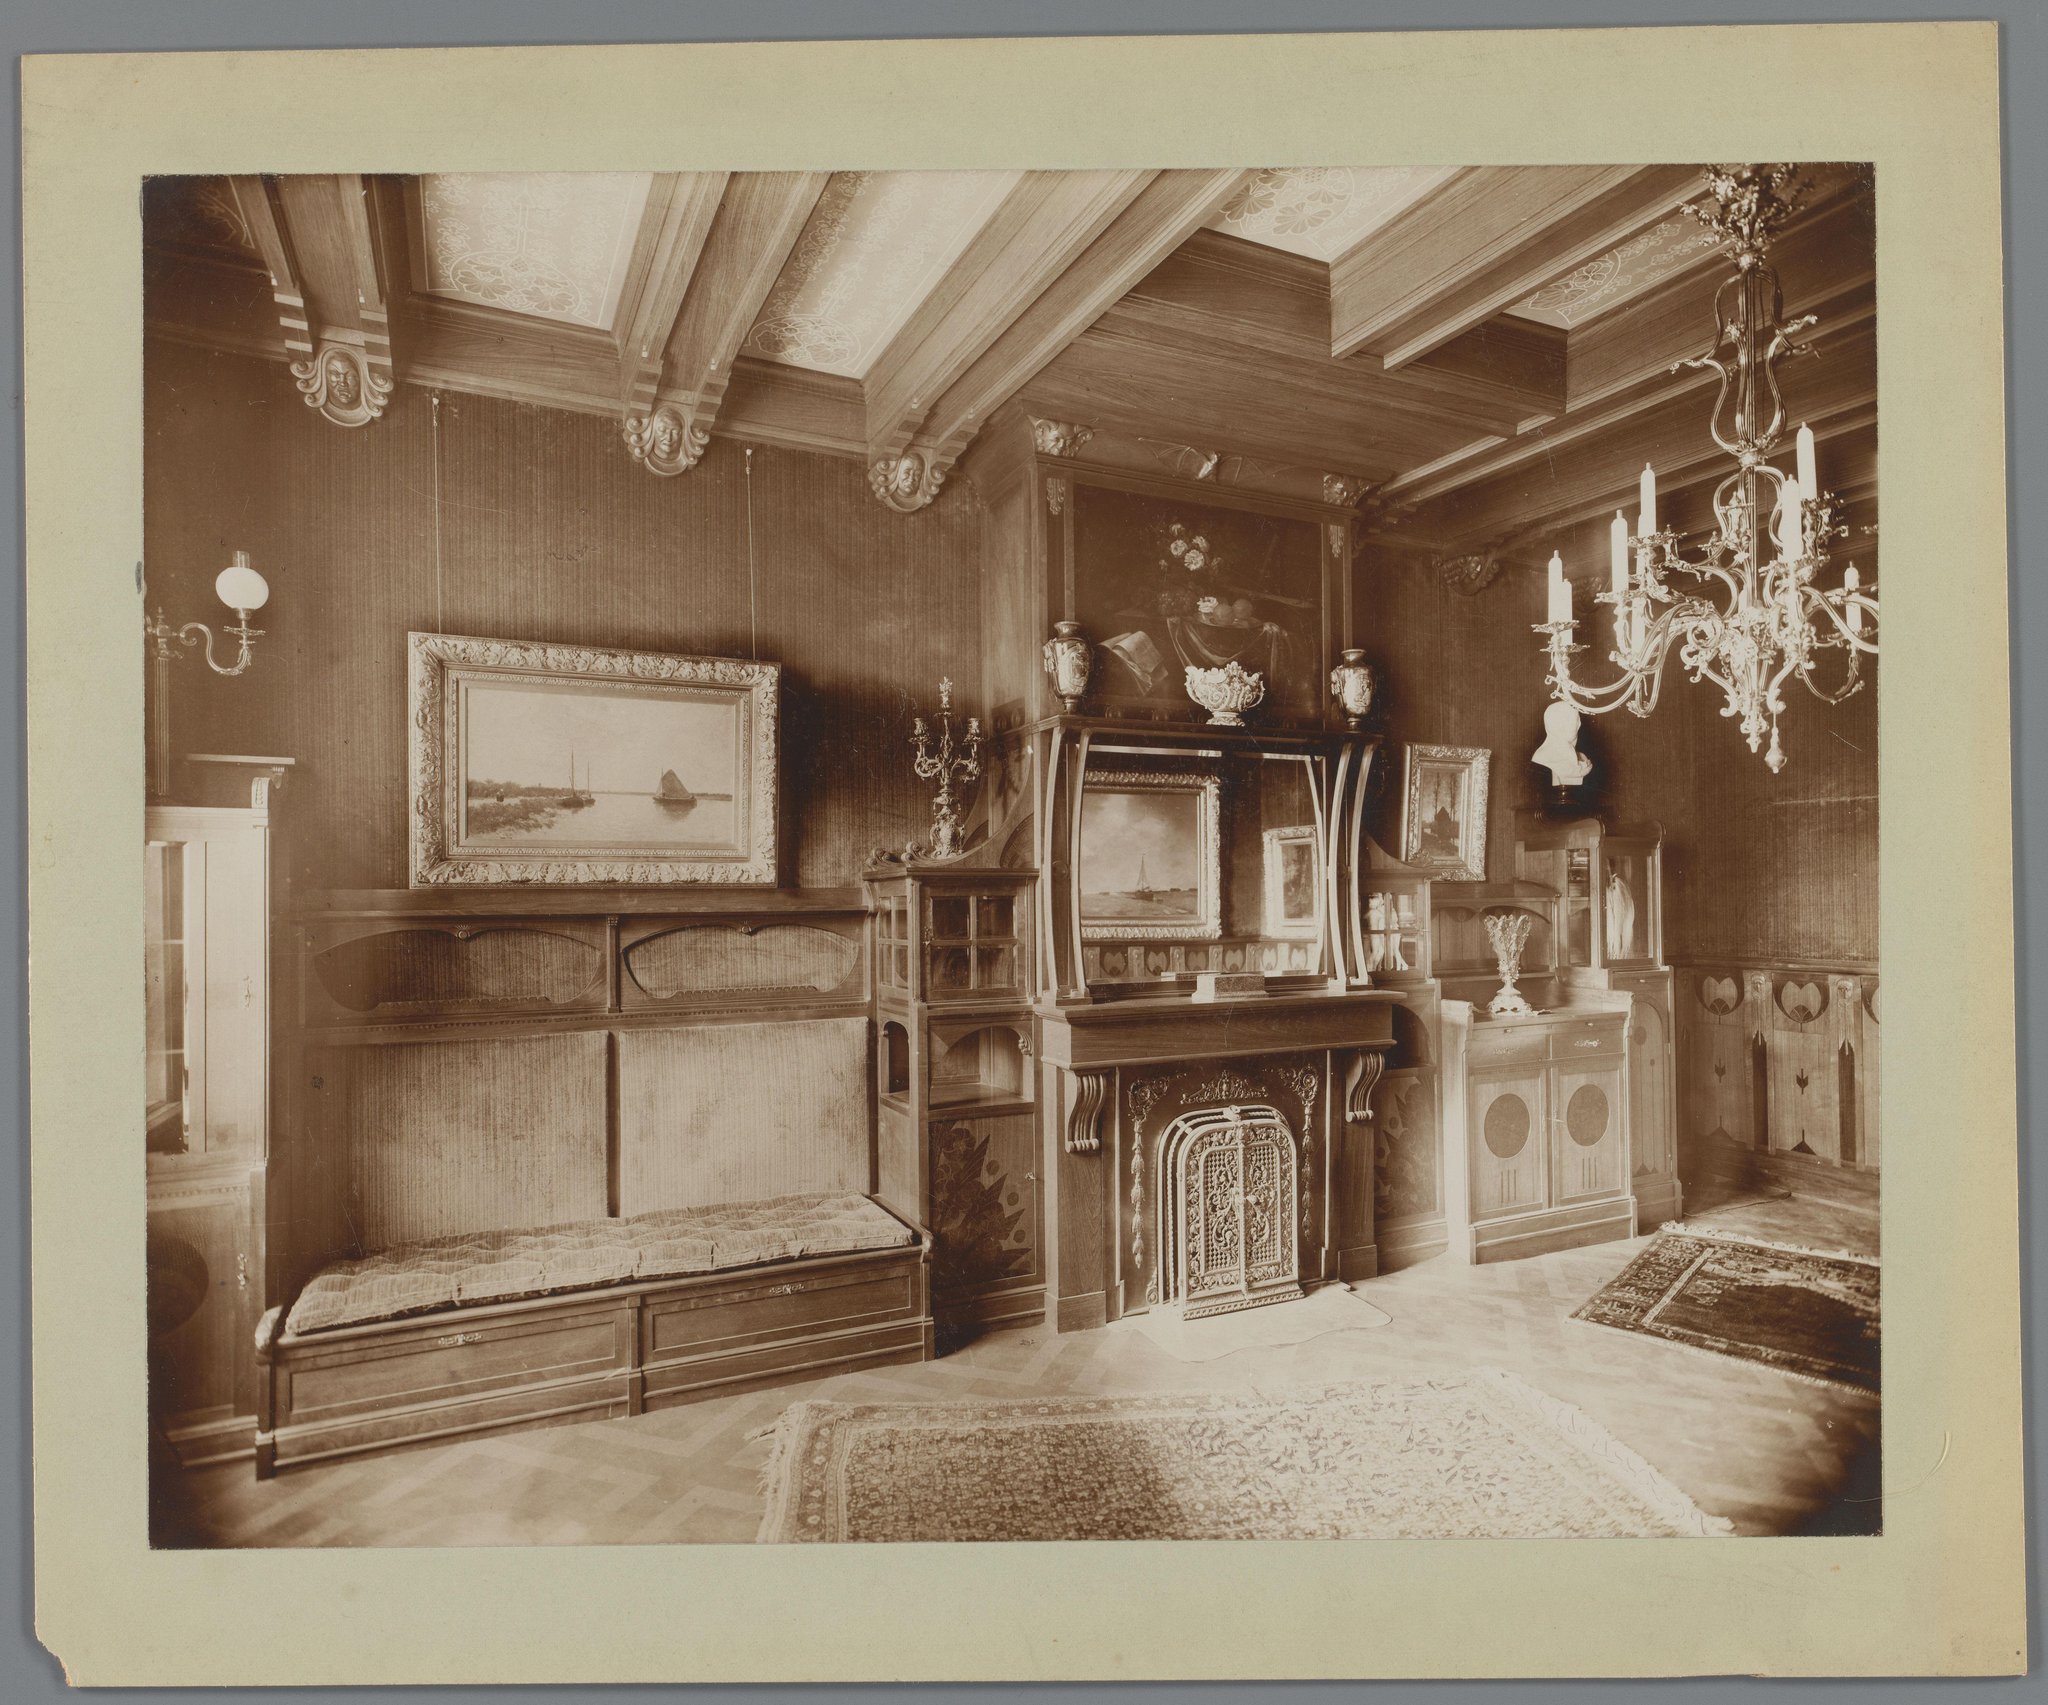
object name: photograph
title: Interieur van Keizersgracht 58, Amsterdam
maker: Anonymous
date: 1901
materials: paper, cardboard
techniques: collodion silver print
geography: amsterdam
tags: living-room, parlour, sitting-room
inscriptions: inscription: ‘Zaal, Keizersgracht, 58./ November, 1901.’